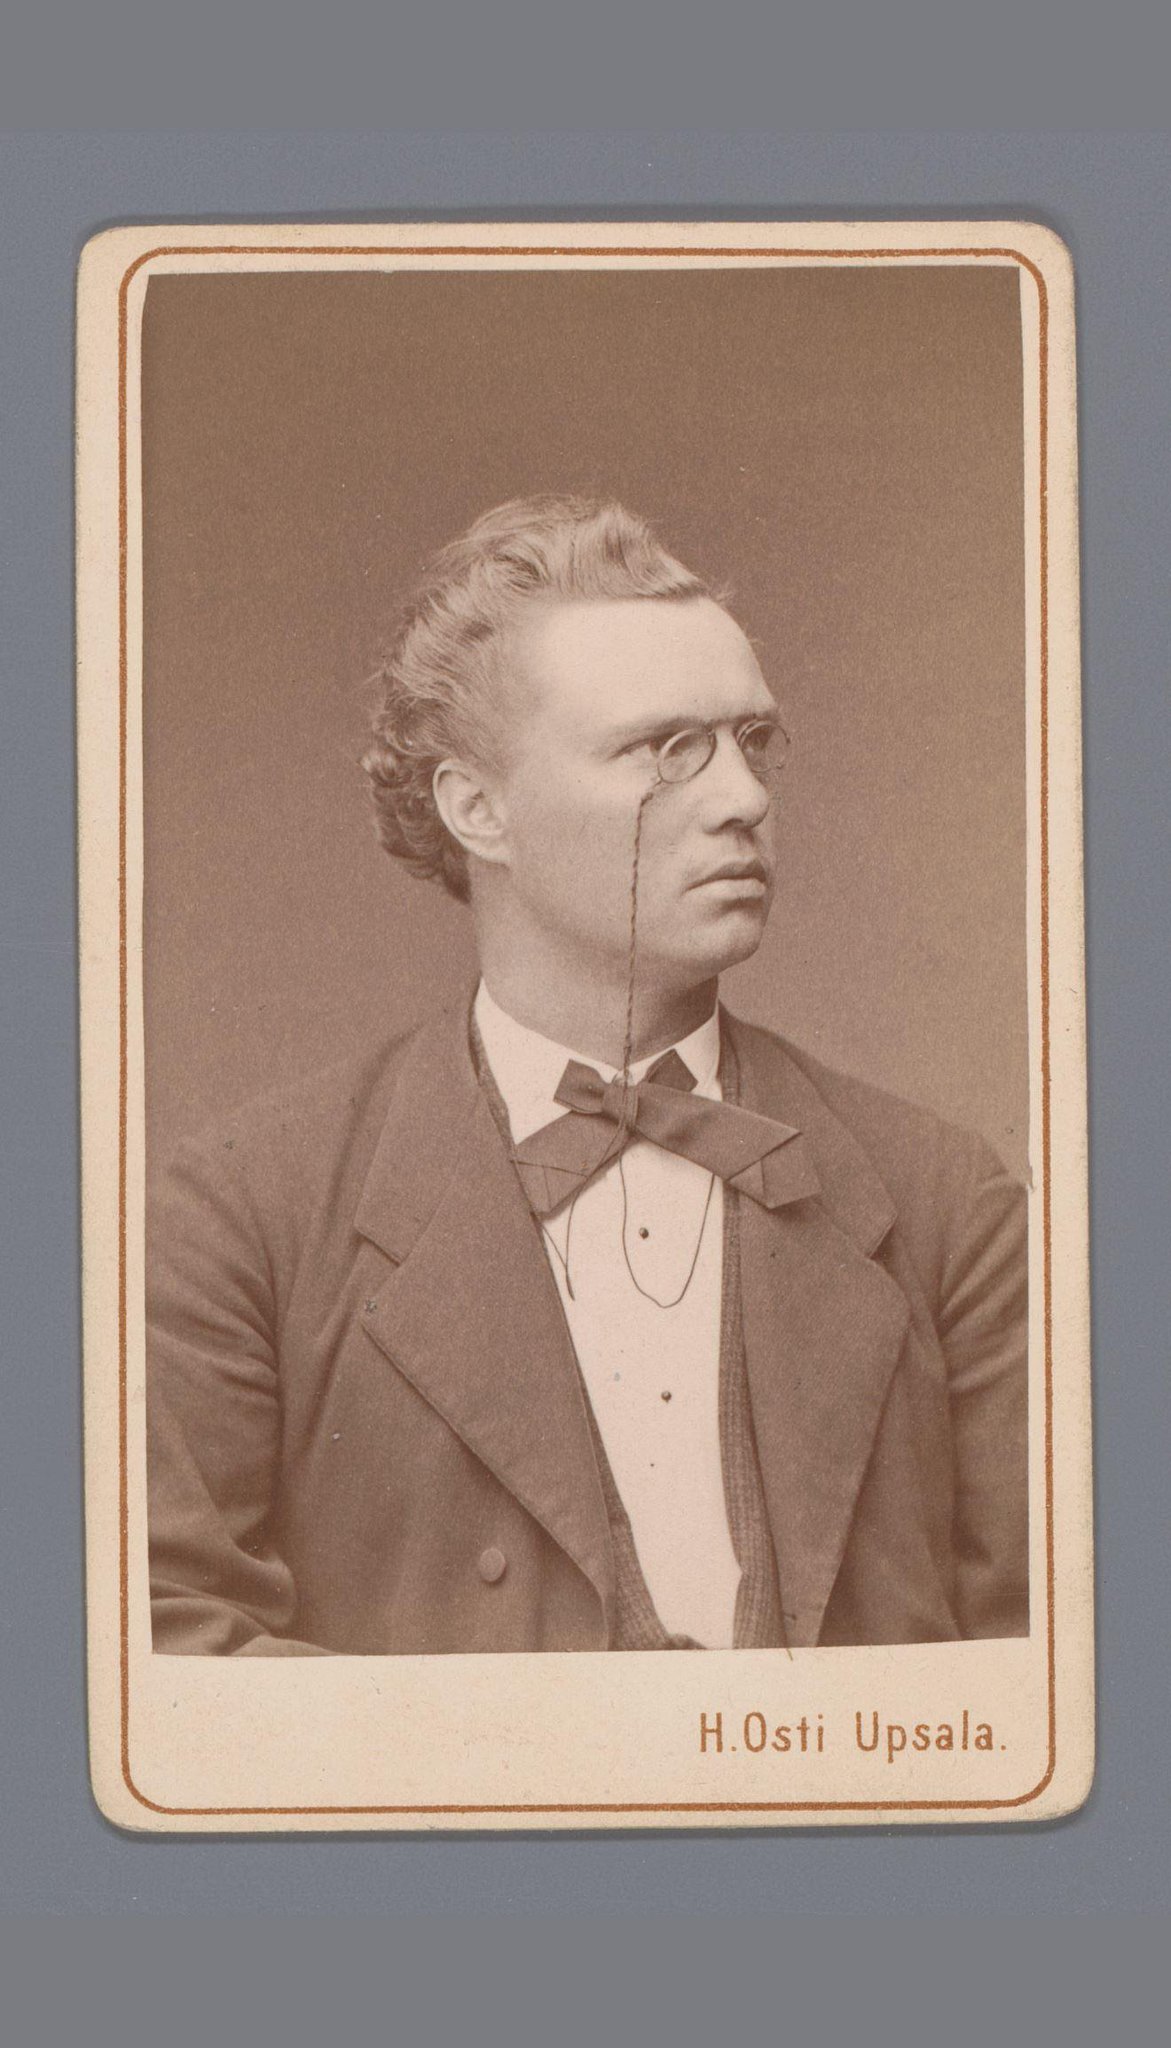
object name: carte de visite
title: Portret van een onbekende man met bril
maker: henri ostis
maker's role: fotograaf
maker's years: 1826-1914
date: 1860-1875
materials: cardboard, paper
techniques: albumen print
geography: uppsala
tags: eyeglasses, spectacles, adult man, historical persons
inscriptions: inscription: ‘Conrad här har de mej/ O. M. [...]’, inscription: ‘HENRI OSTIS/ FOTOGRAFI ATELIER/ Copiering efter Taflor Fotografier M M./ verkställes i alla storlekar/ UPSALA./ Stora Kungsgatan No. 55./ Plåten förvaras for efterbeställnning’